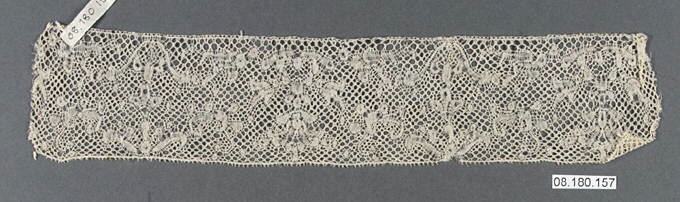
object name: strip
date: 1701-1733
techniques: lace